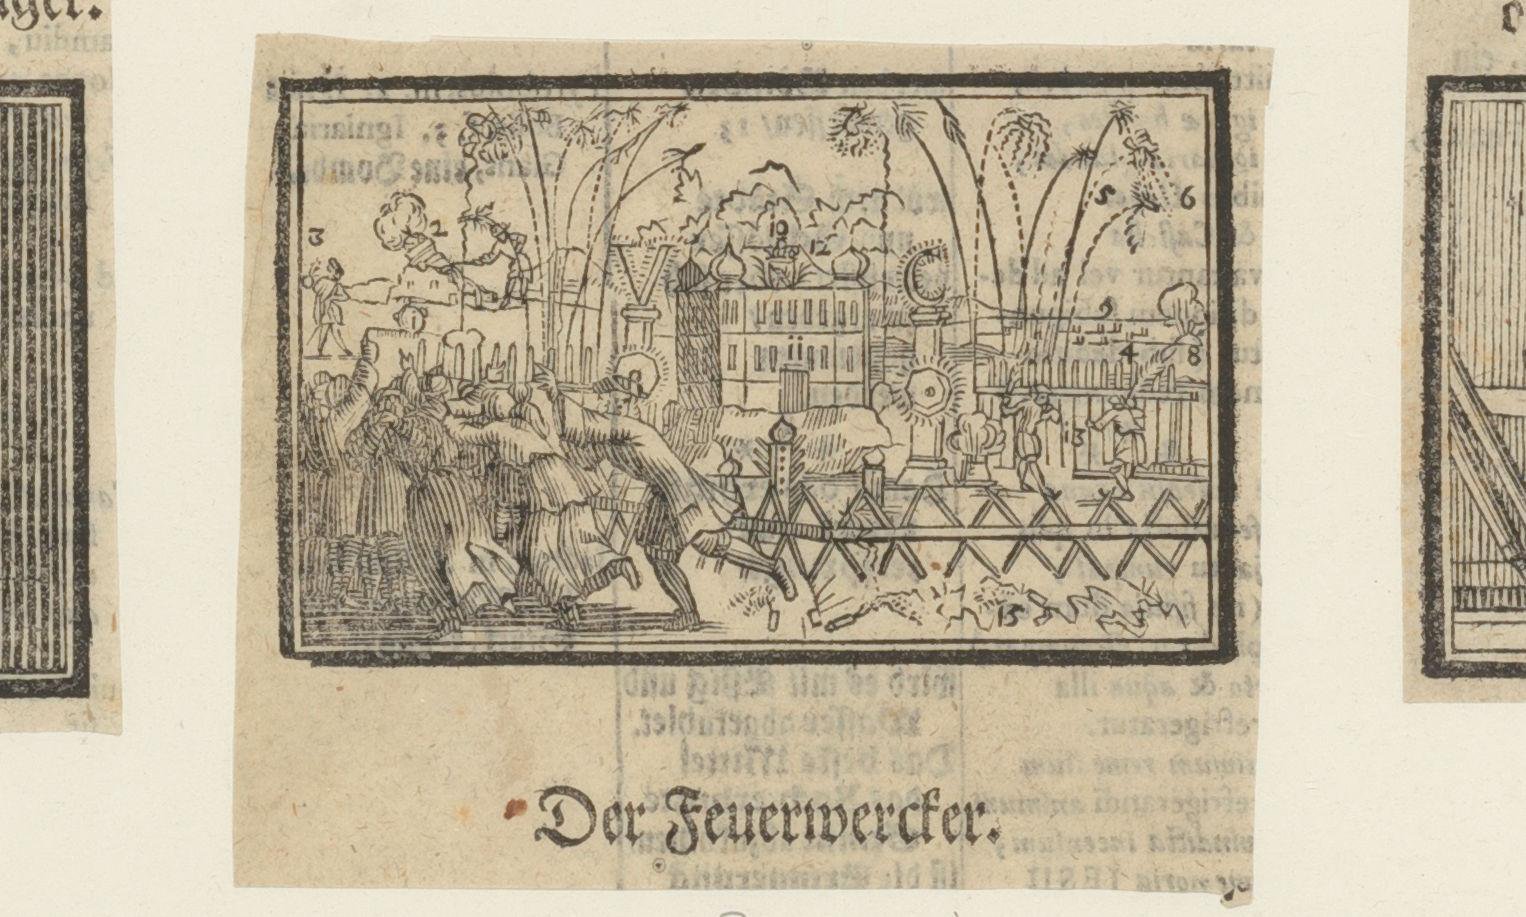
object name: print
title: Vuurwerkmaker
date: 1719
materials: paper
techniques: letterpress printing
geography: nuremberg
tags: handicrafts, craftsman at work, bonfire, fire-works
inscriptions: stamp, collector's mark: Lugt 1641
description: Prent uit: Comenius, Johannes Amosius. Orbis sensualium picti pars prima (...). Neurenberg: Martin Endter, 1719, dl. 2, p. 274. Prent eerder gebruikt in: Comenius, Johannes Amosius. Orbis Sensualium Picti denuo aucti Pars Secunda (...). Neurenberg: Martin Endter, 1730, dl. 2.